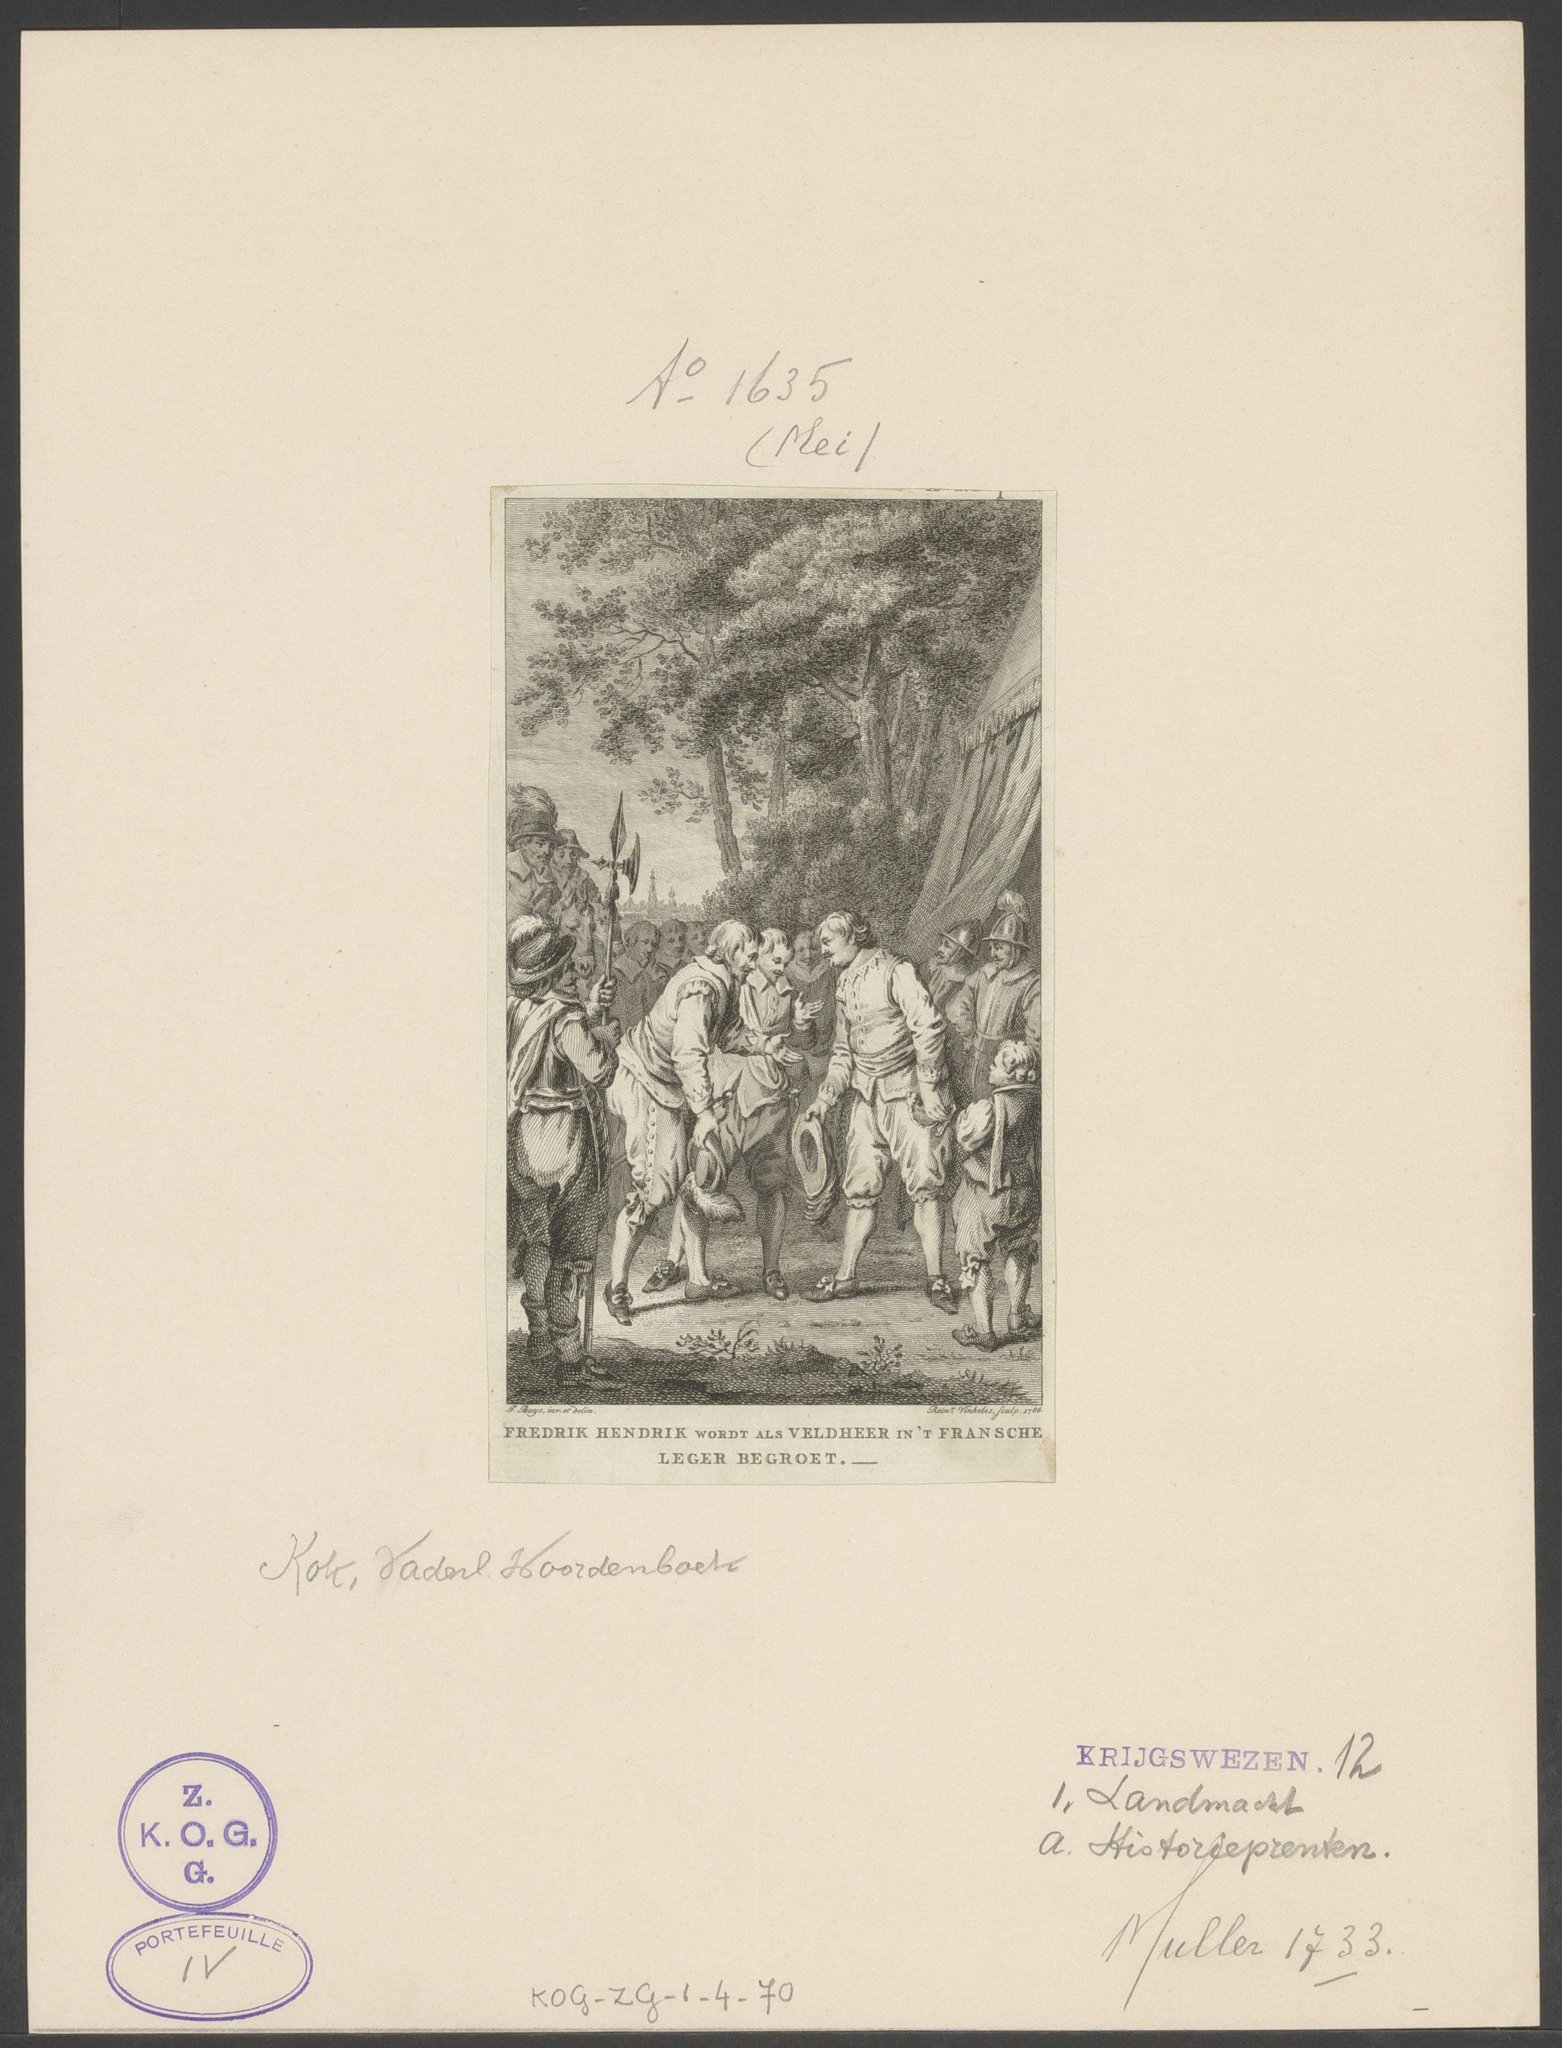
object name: history print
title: Frederik Hendrik wordt als veldheer in het Franse leger begroet, 1635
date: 1786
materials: paper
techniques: etching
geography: northern netherlands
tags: delft, the hague, frederick henry (prince of orange), siege, position war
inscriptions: collector's mark: Lugt 1641, collector's mark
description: Gebruikt als illustratie in: Jacobus Kok, Vaderlandsch Woordenboek, Johannes Allart, Amsterdam 1785-1799, 35 delen, dl. XVII, pl. II. Staat met de letter.